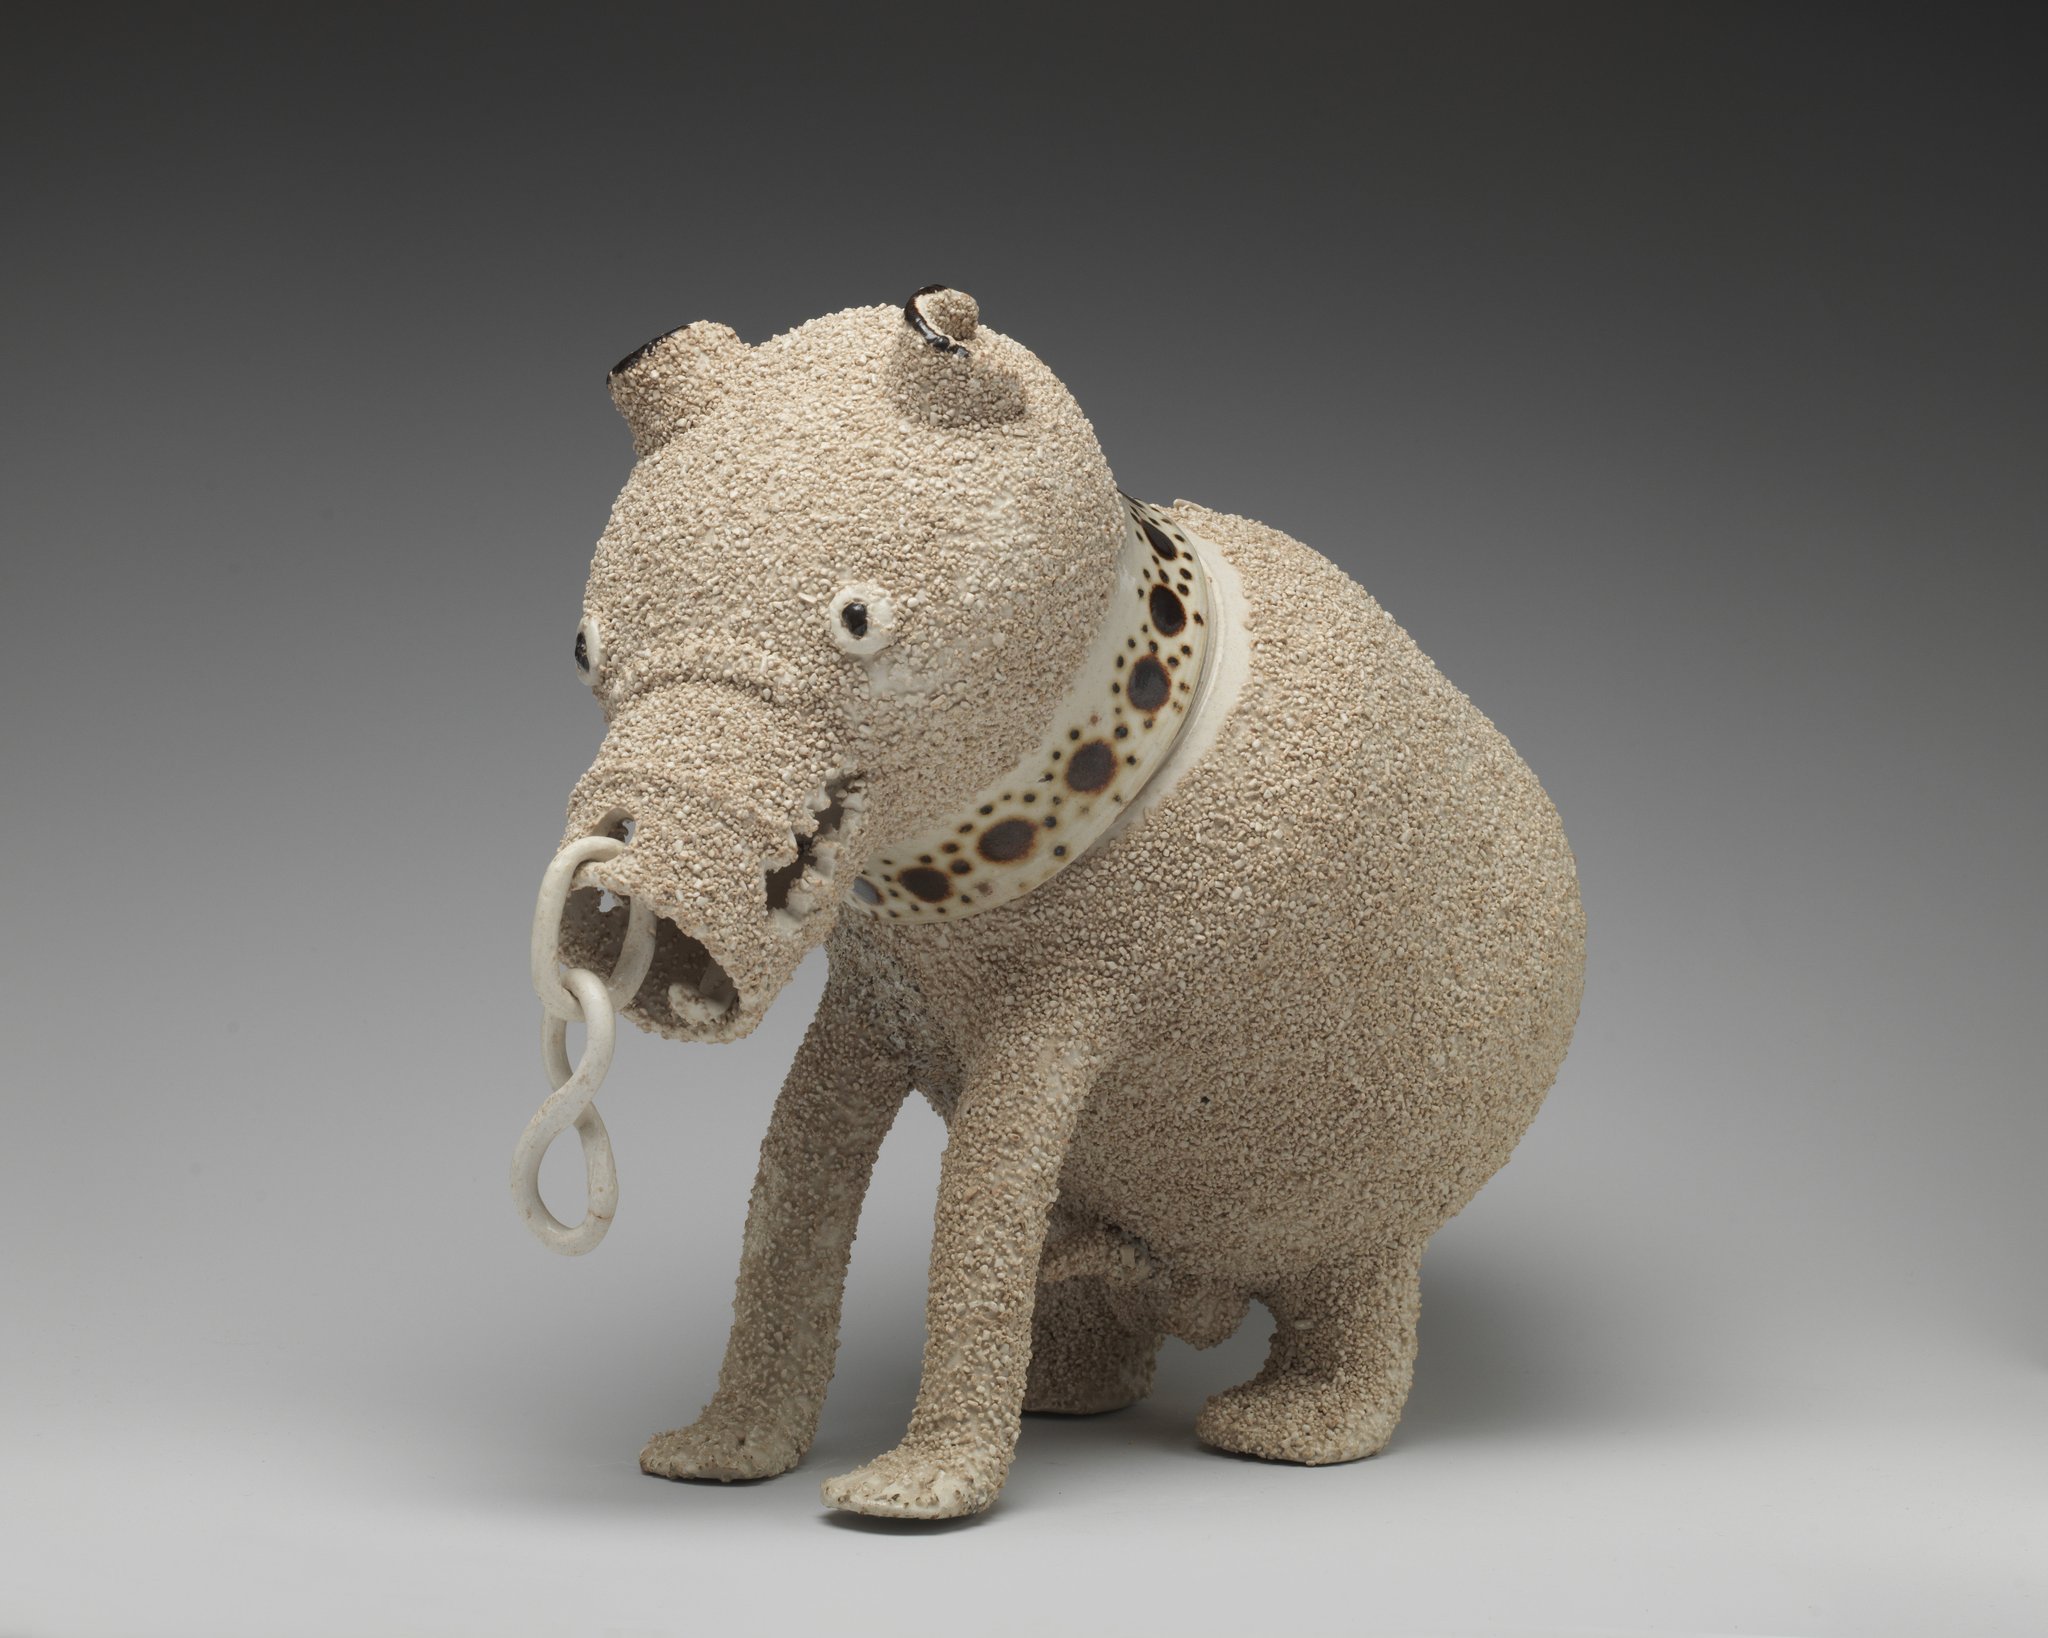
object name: bottle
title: Bear bottle (one of a pair)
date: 1740-1750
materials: stoneware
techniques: salt glaze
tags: bears